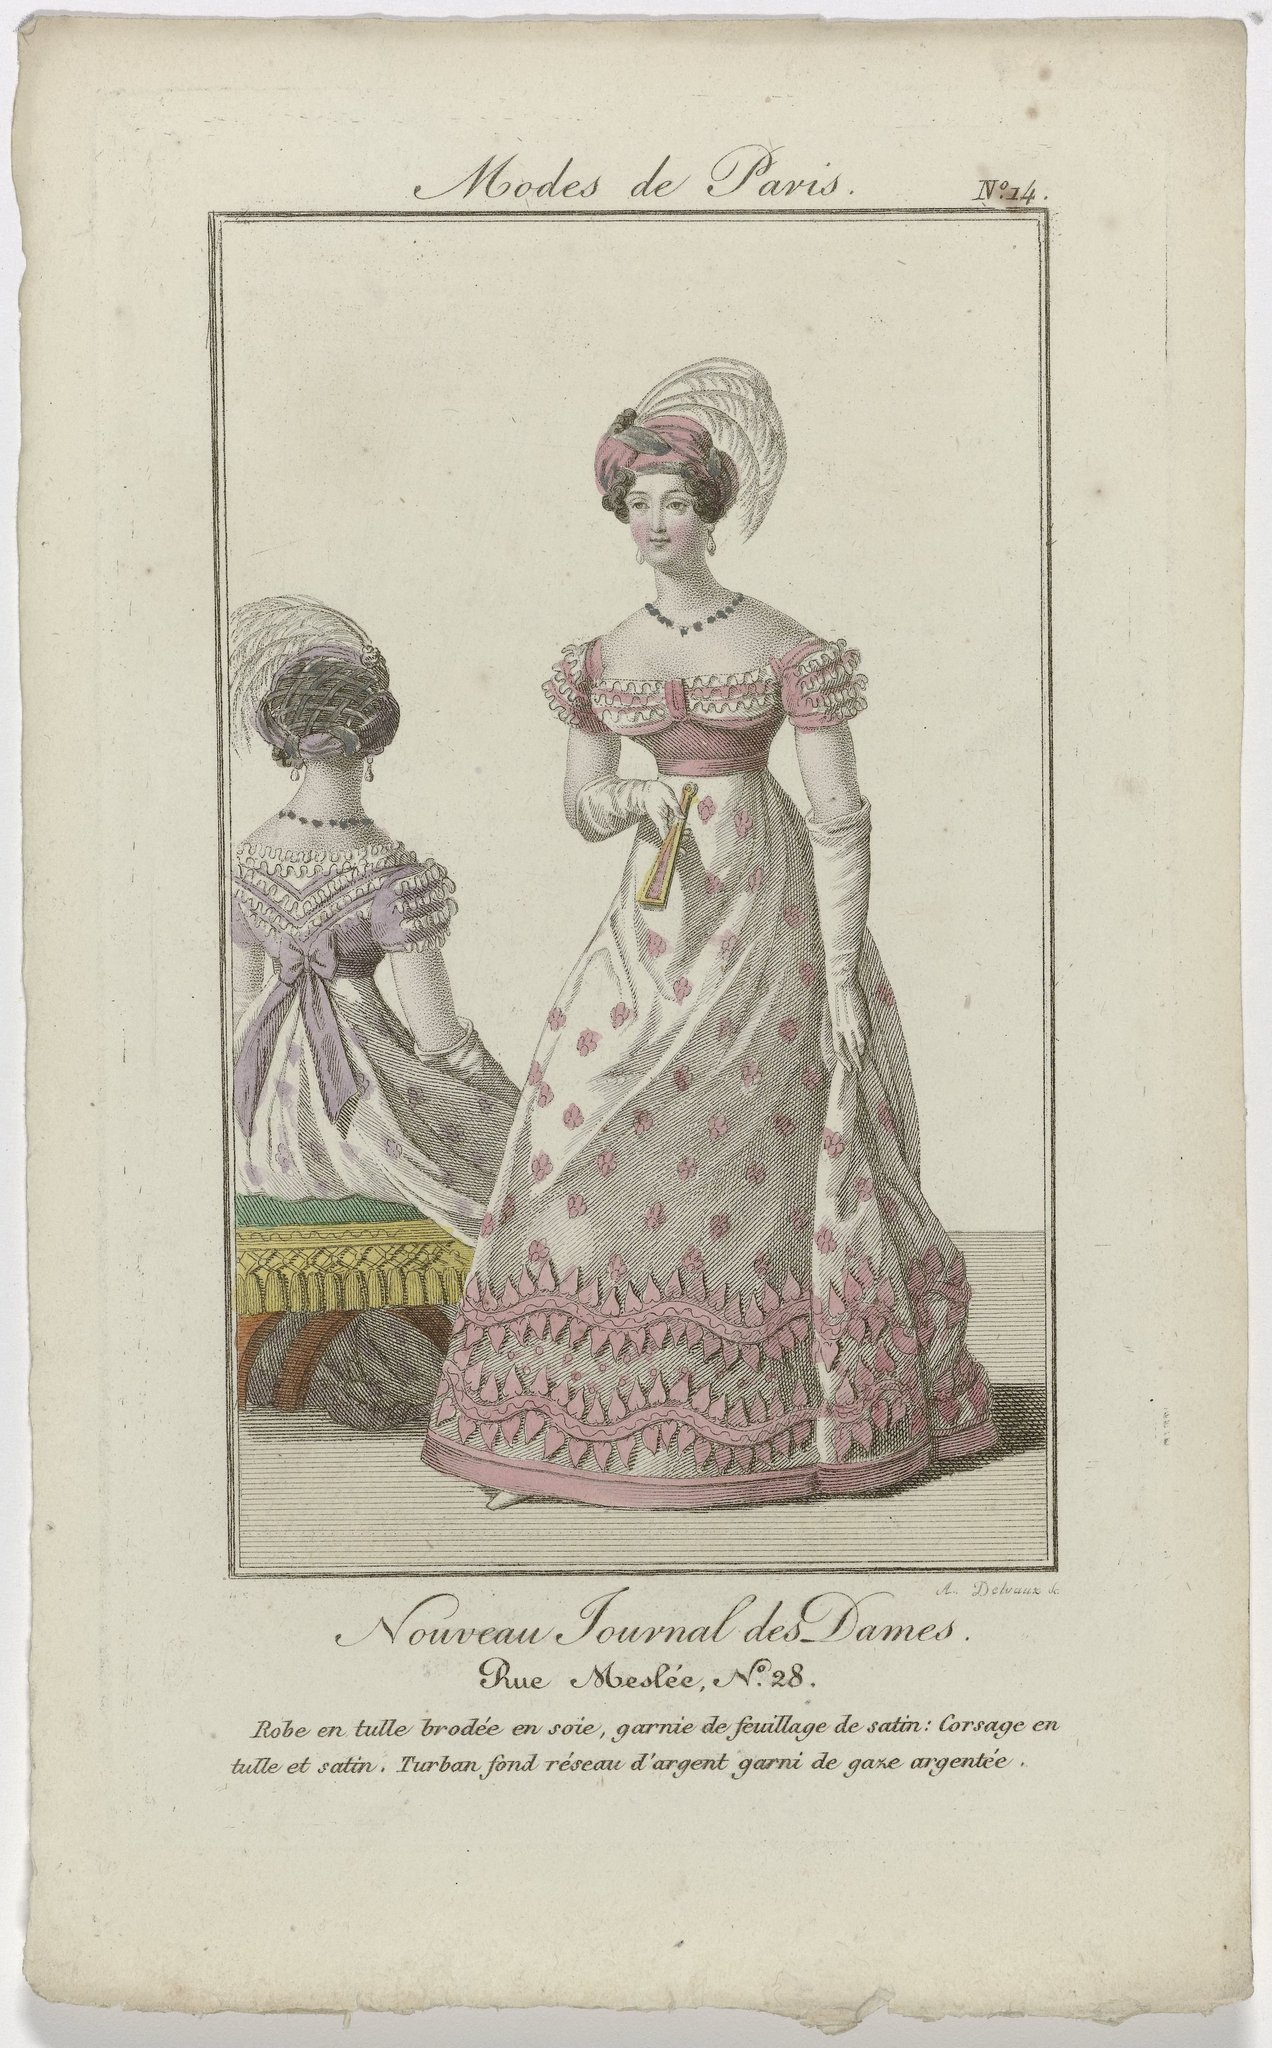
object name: fashion print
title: Nouveau Journal des Dames, 1821, Pl. 14 : Robe en tulle brodée en soi (...)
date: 1821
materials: paper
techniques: engraving, hand coloring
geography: paris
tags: ear-rings (+ women's clothes), head-gear: turban (+ women's clothes), gloves, mittens (long gloves) (+ women's clothes), embroidery (ornamentation) (+ women's clothes), fashion plates, dress, gown (+ women's clothes), stool, fan (+ women's clothes), necklace (+ women's clothes)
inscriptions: address: ‘Rue Meslée, No. 28.’, title: ‘Nouveau Journal des Dames.’, title: ‘Modes de Paris.’, caption: ‘Robe en tulle brodée en soie, garnie de feuillage de satin: Corsage en tulle et satin. Turban fond réseau d'argent garni de gaze argentée.’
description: Staande vrouw gekleed in een japon van tule geborduurd met zijde, afgezet met loof van satijn. Het lijfje is van tule en satijn. Op het hoofd een tulband, aan de achterzijde een zilverkleurig (haar)net, versierd met 'gaze argentée' (lamé?). Verdere accessoires: oorbellen, collier, lange handschoenen, waaier. Naast haar zit een vrouw op een tabouret, op de rug gezien, gekleed in eenzelfde japon. Prent uit het modetijdschrift Nouveau Journal des Dames, Parijs, van 5 juli 1821 tot eind december 1821. Van januari 1822 tot 1868 was het modetijdschrift getiteld: Petit Courrier des Dames.